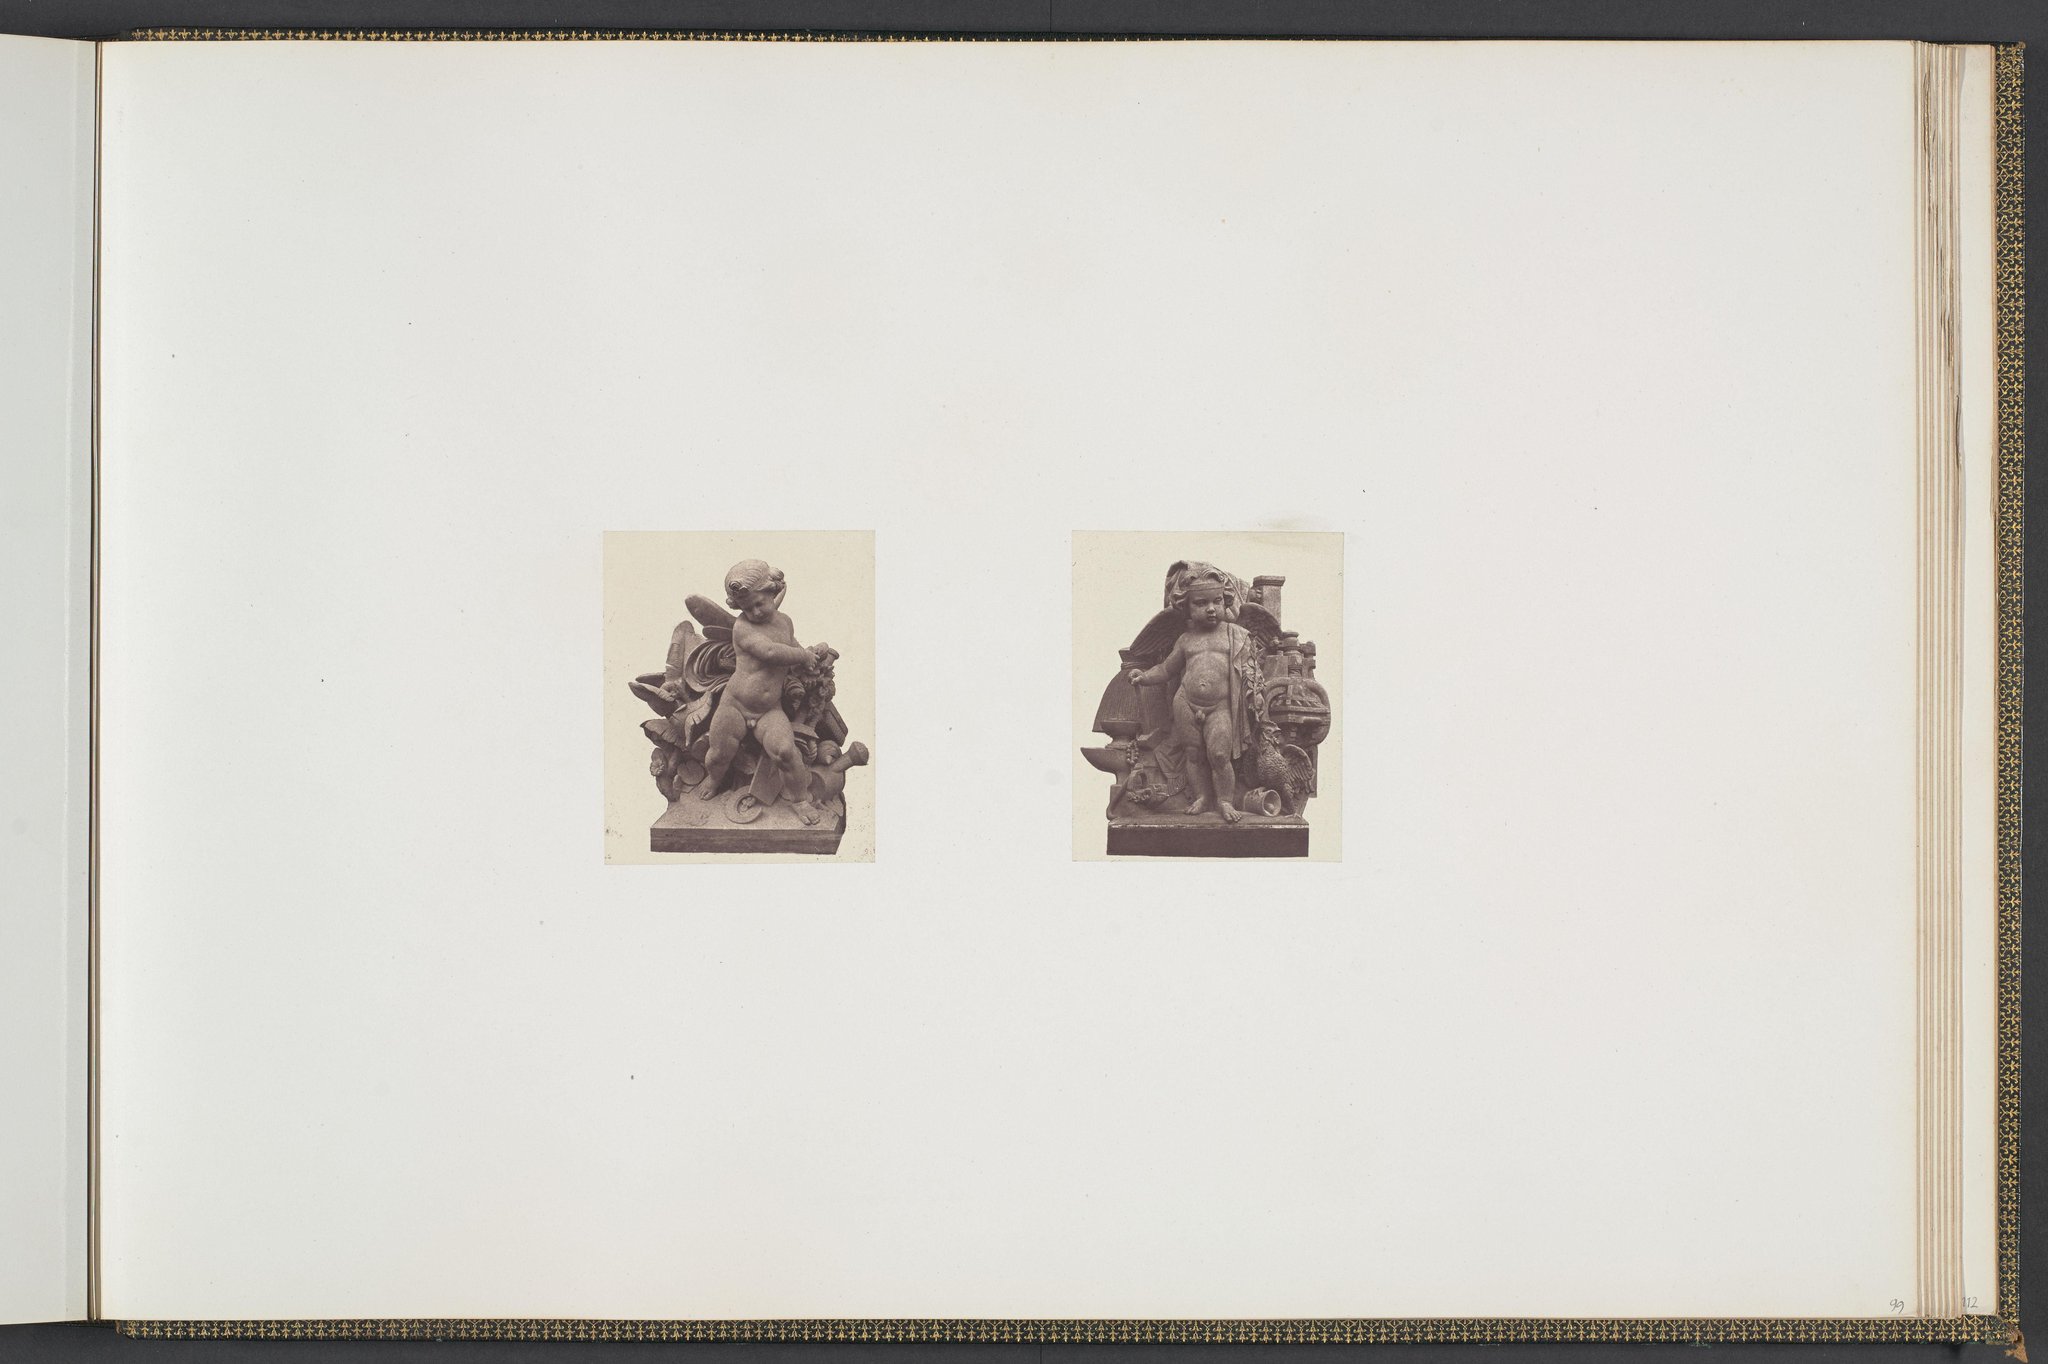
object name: album leaf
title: Gipsmodellen voor beeldhouwwerken op het Palais du Louvre: links "L'Horticulture" door Théodore François Devaulx en rechts "L'Industrie" door Célestin Anatole Calmels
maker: édouard denis baldus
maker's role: fotograaf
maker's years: 1813-1889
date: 1855-1857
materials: paper, photographic support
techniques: salted paper print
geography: paris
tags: piece of sculpture, reproduction of a piece of sculpture, permanent exhibition, museum, paris, tuileries palace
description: Onderdeel van Réunion des Tuileries au Louvre 1852-1857, album 2.